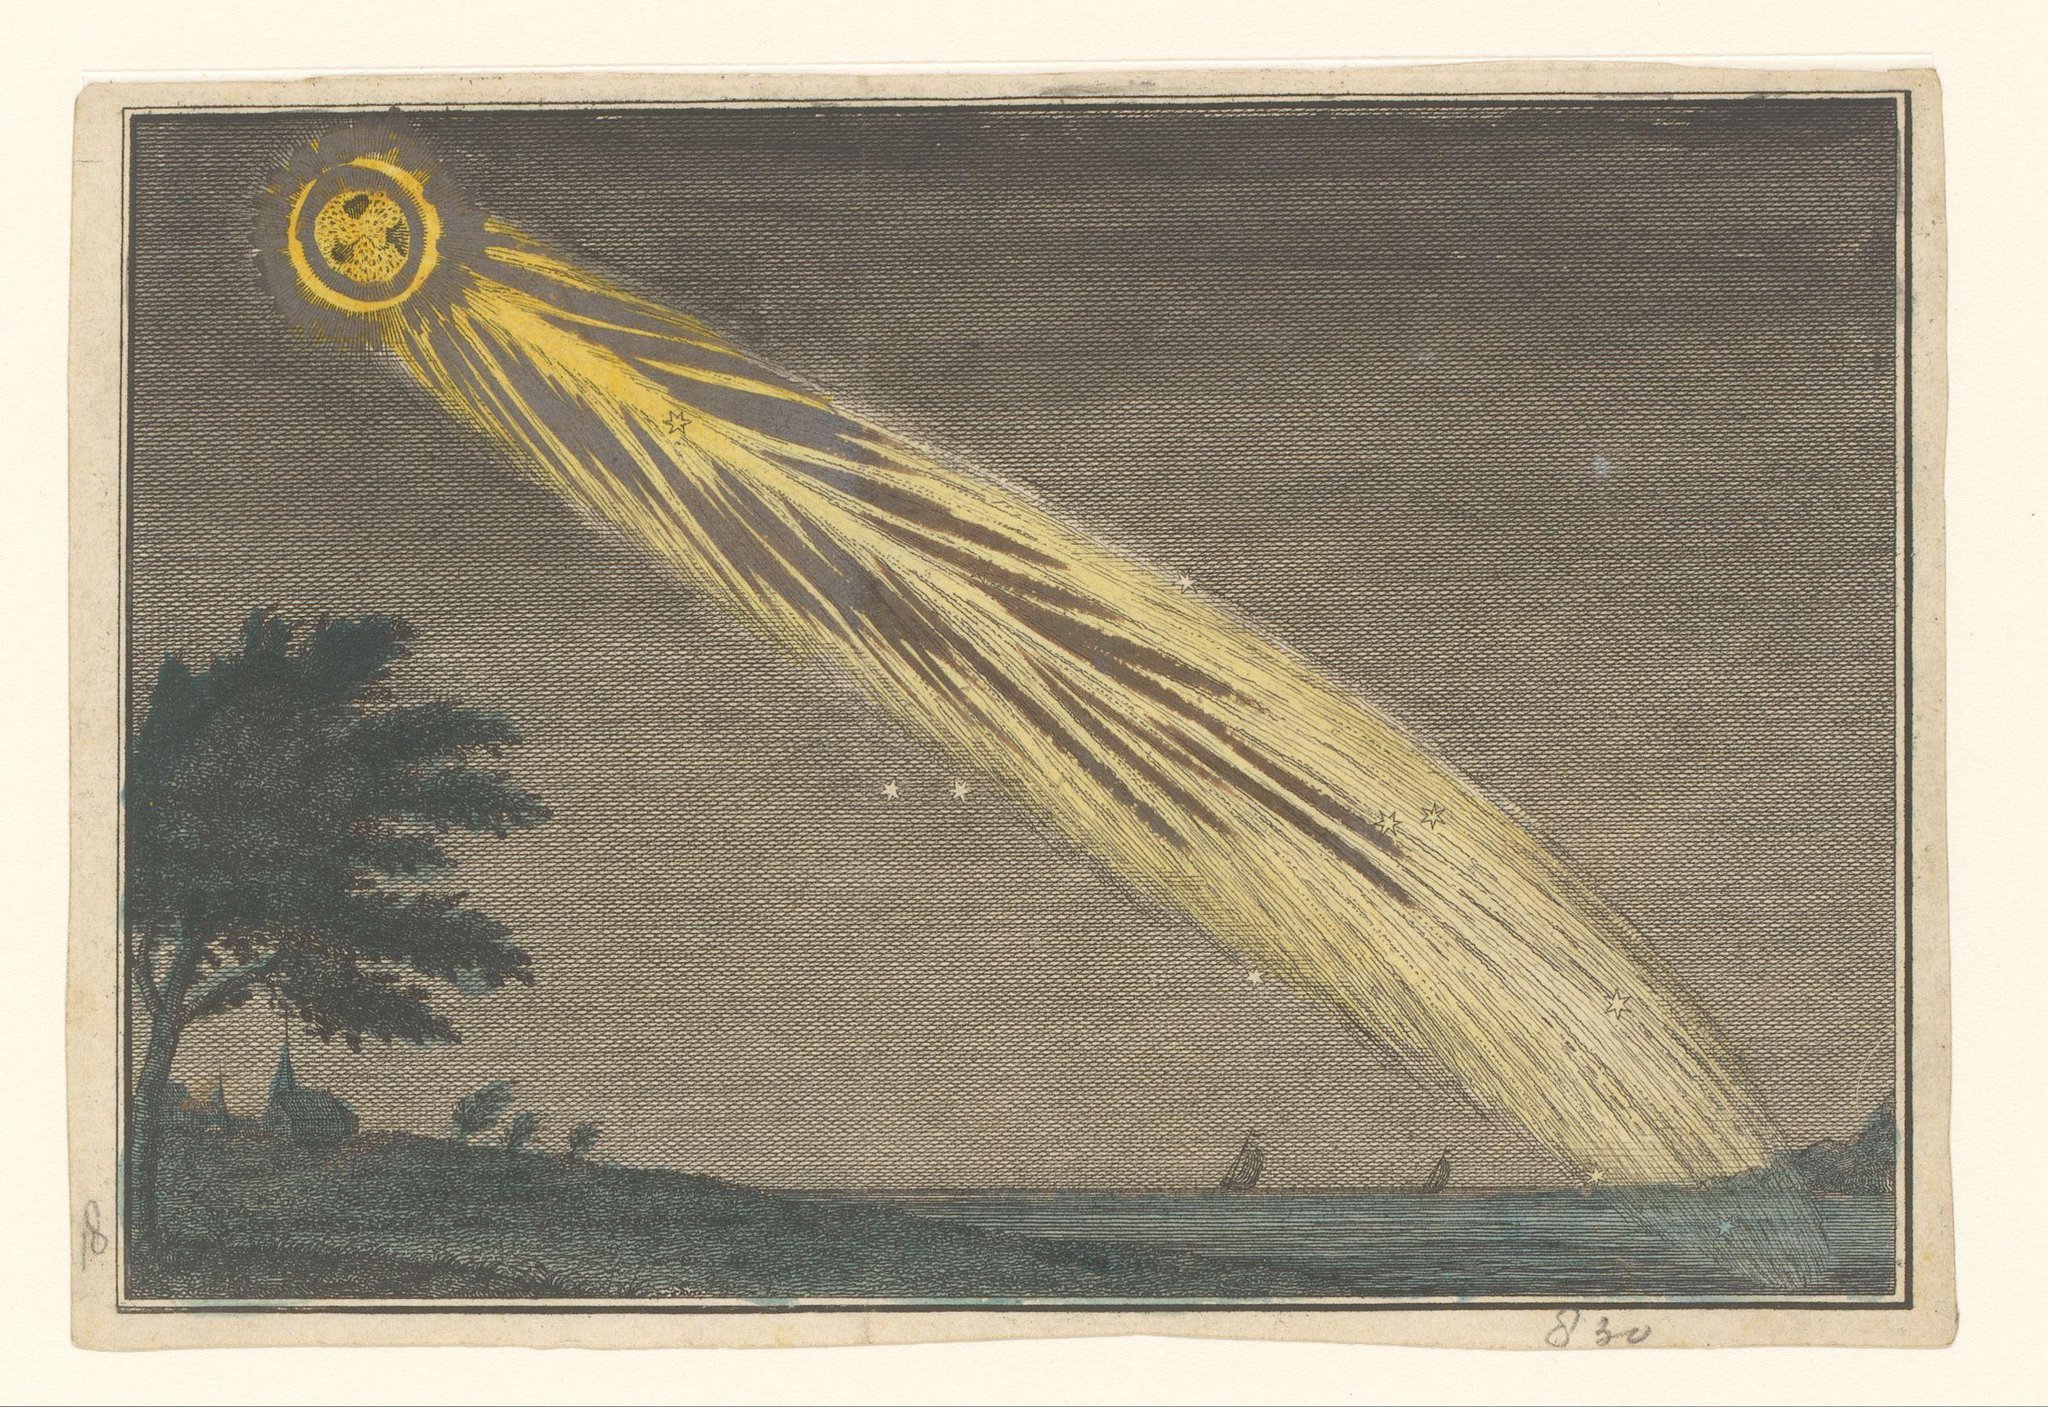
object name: print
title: Komeet, waarschijnlijk komeet Halley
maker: Anonymous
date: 1700-1800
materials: paper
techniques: engraving, etching, hand coloring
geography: northern netherlands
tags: comet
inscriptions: collector's mark: Lugt 2228